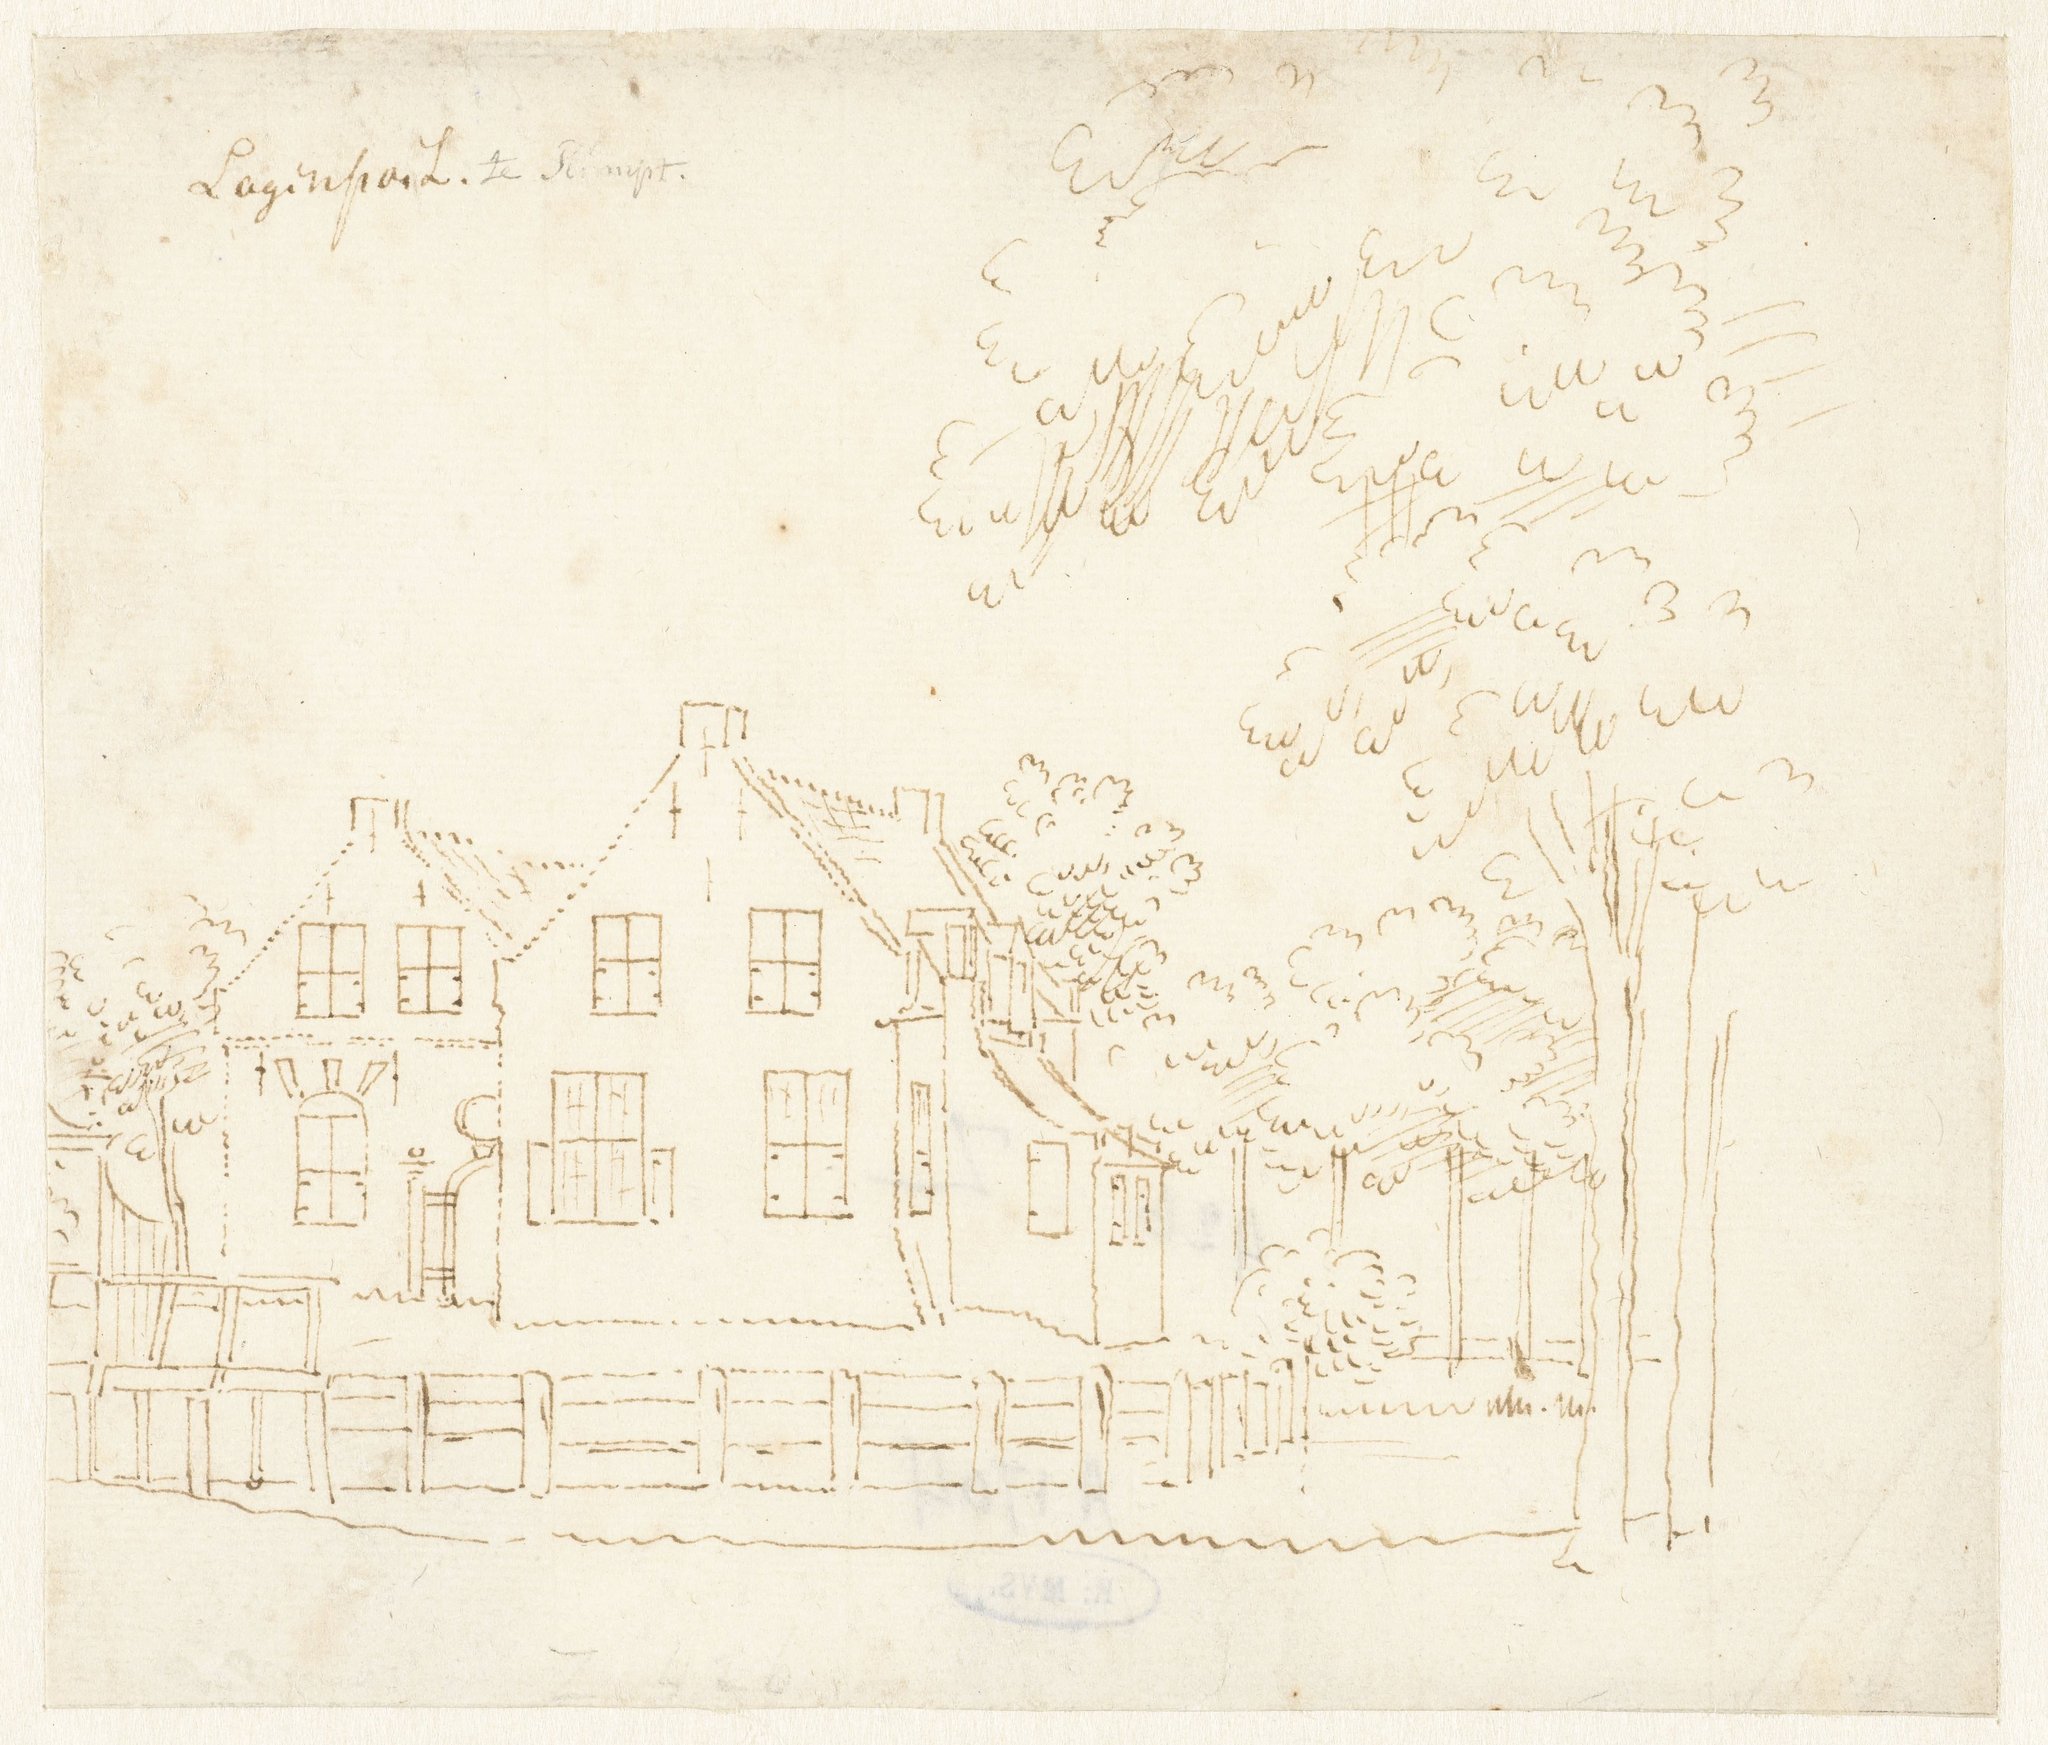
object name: drawing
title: Het huis Lagenpoel te Rumpt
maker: cornelis pronk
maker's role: draughtsman, painter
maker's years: 1691-1759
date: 1701-1759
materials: ink, paper, pencil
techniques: pen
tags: castle